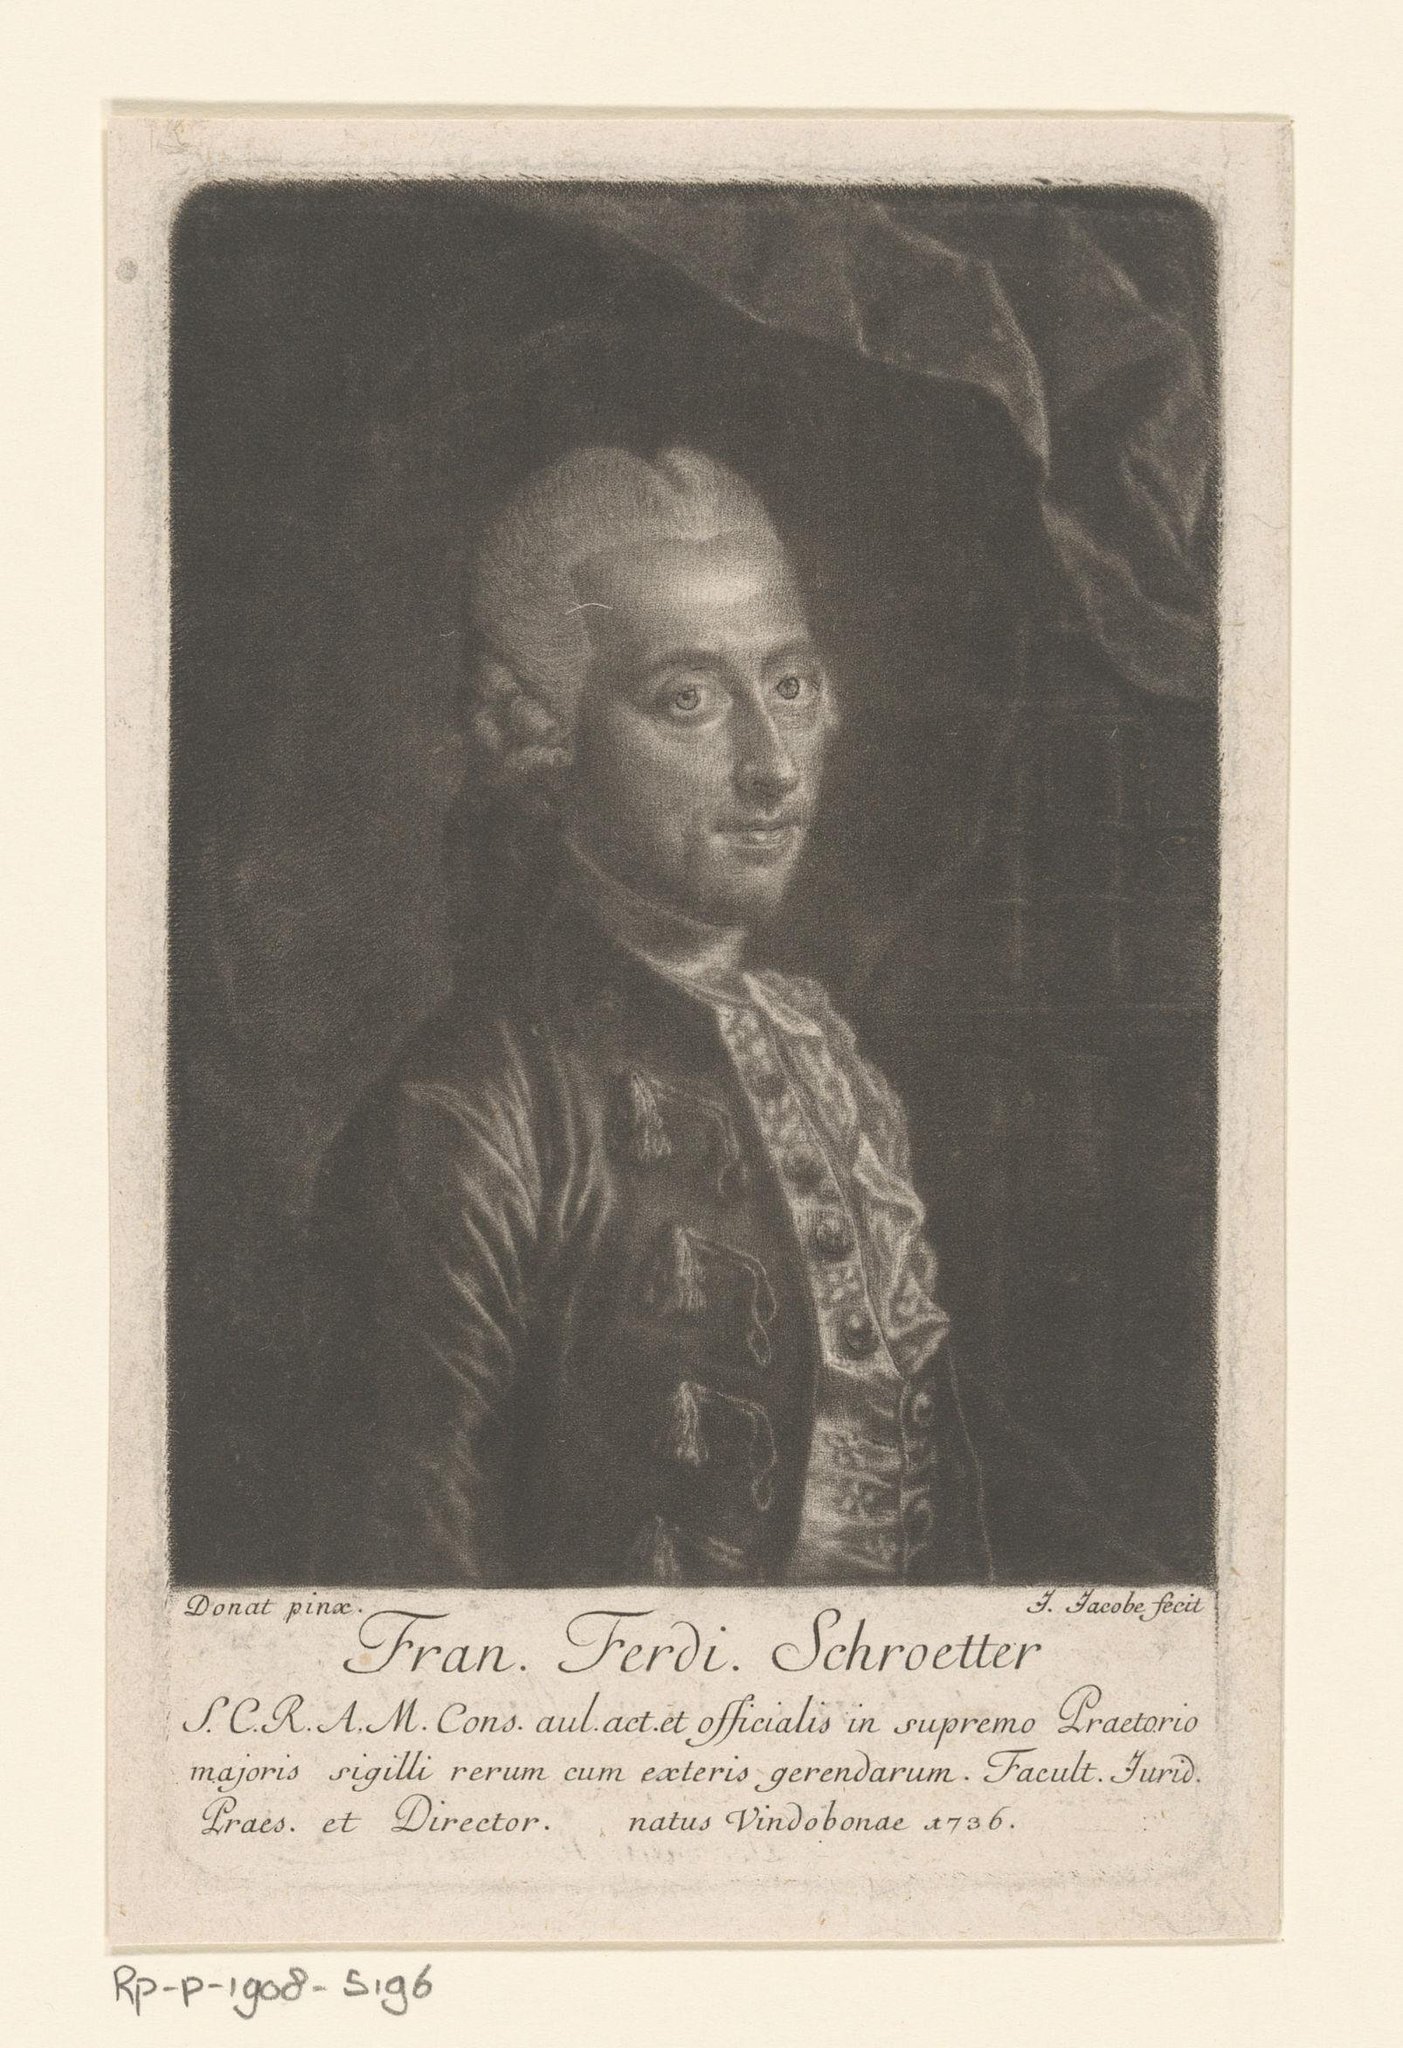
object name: print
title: Portret van Franz Ferdinand von Schrötter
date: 1746-1780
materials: paper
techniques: mezzotint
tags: vienna, bookshelves, historical persons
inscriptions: collector's mark: Lugt 2228